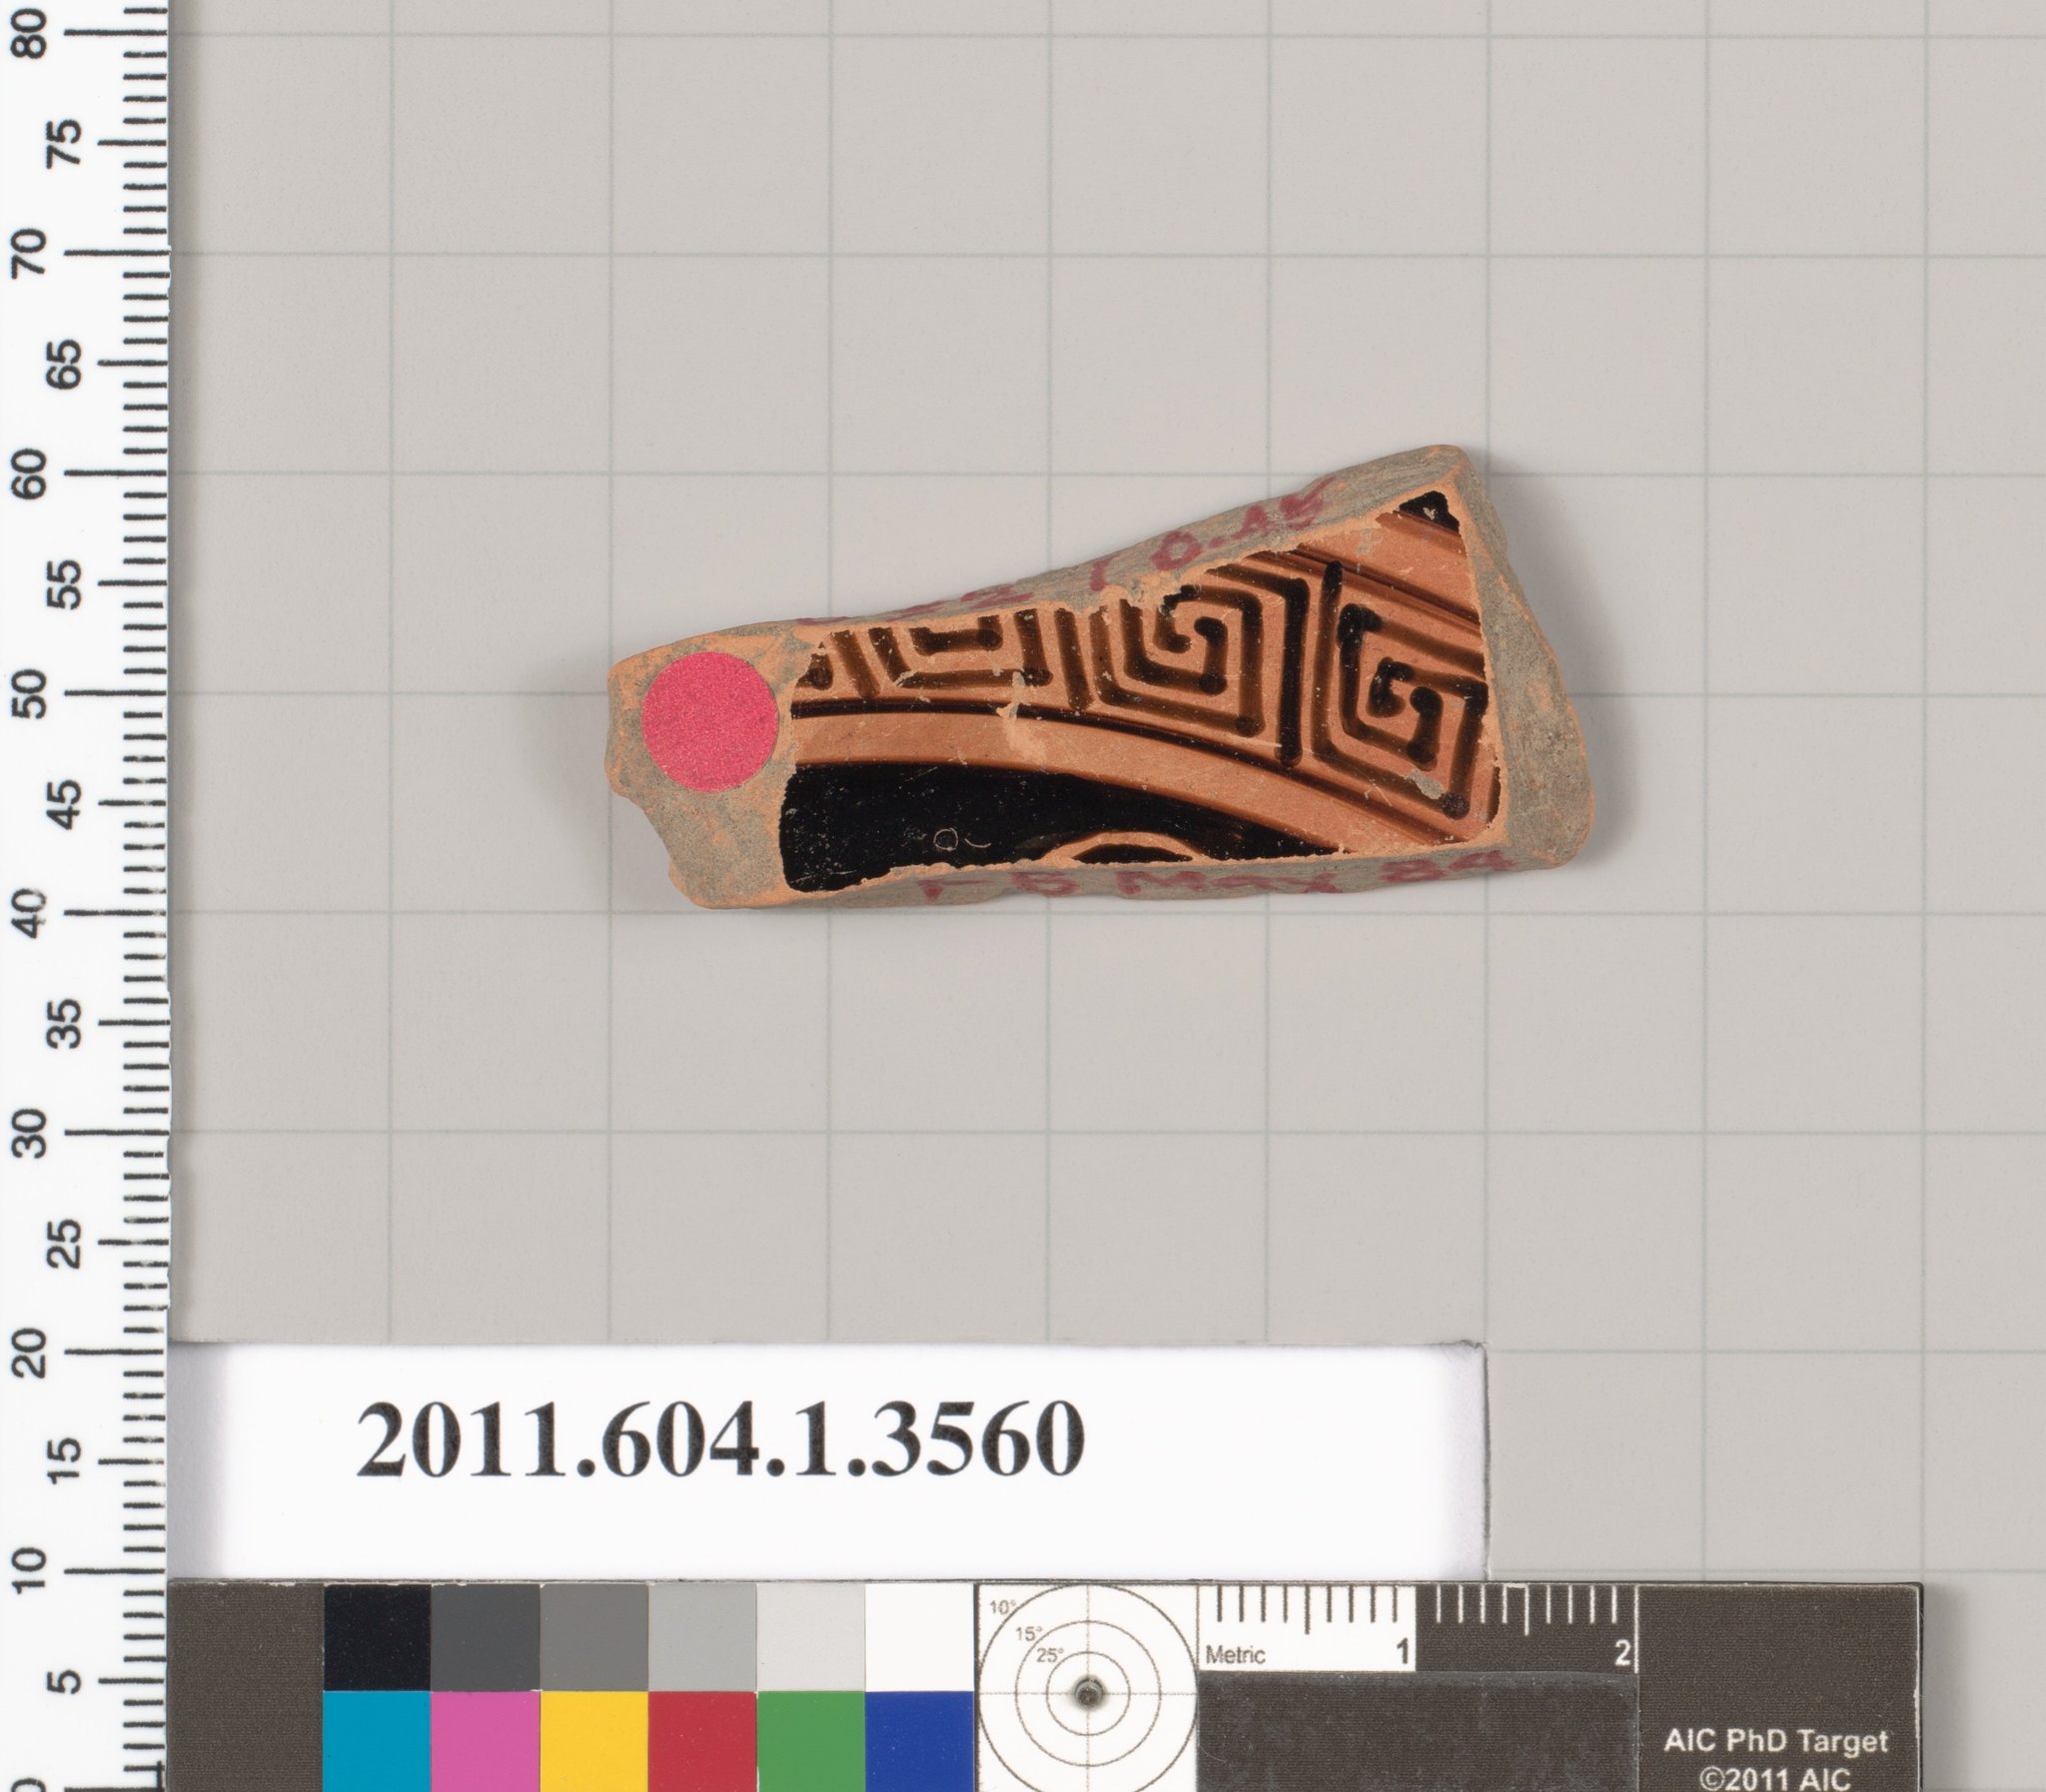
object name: kylix fragment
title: Terracotta fragment of a kylix (drinking cup)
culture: greek, attic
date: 475-451 BCE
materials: terracotta